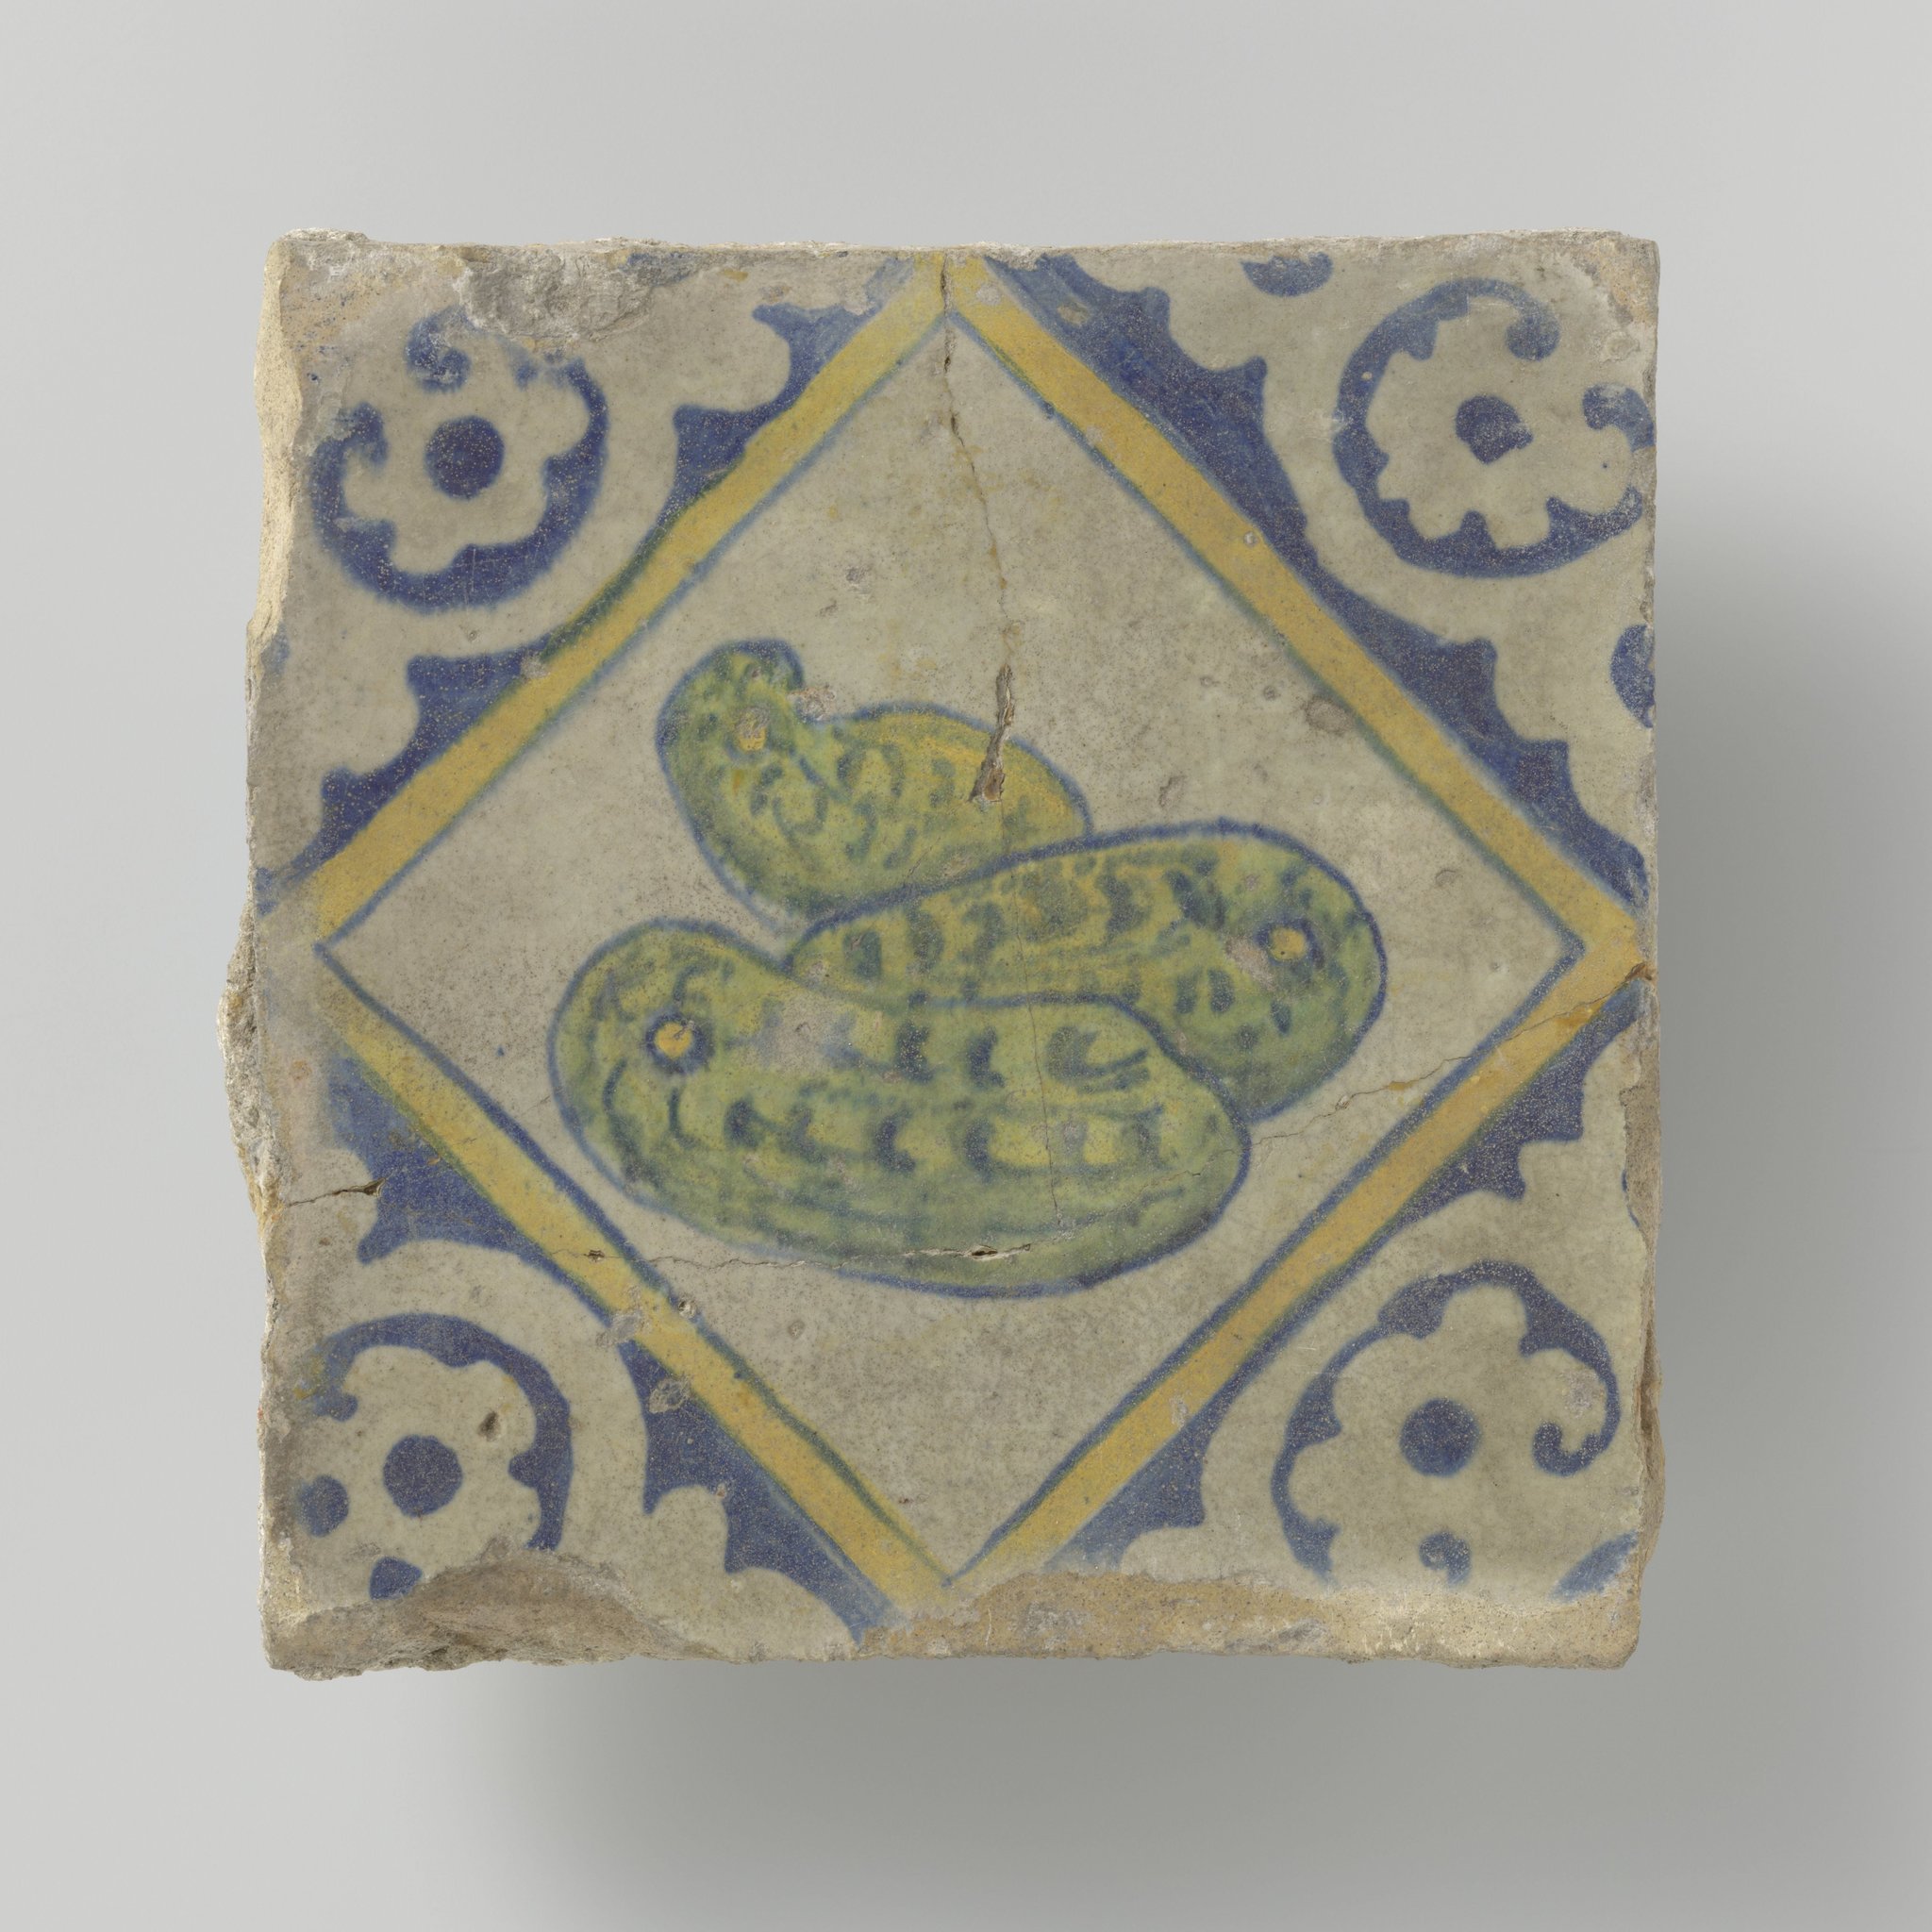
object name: tile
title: Tegel met komkommers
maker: Anonymous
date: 1580-1625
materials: earthenware, glaze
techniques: maiolica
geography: netherlands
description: Tegel met veelkleurig (blauw, oranje, geel en groen) geschilderde komkommers omlijst door een kwadraat met in de hoeken, ornament in vultechniek.